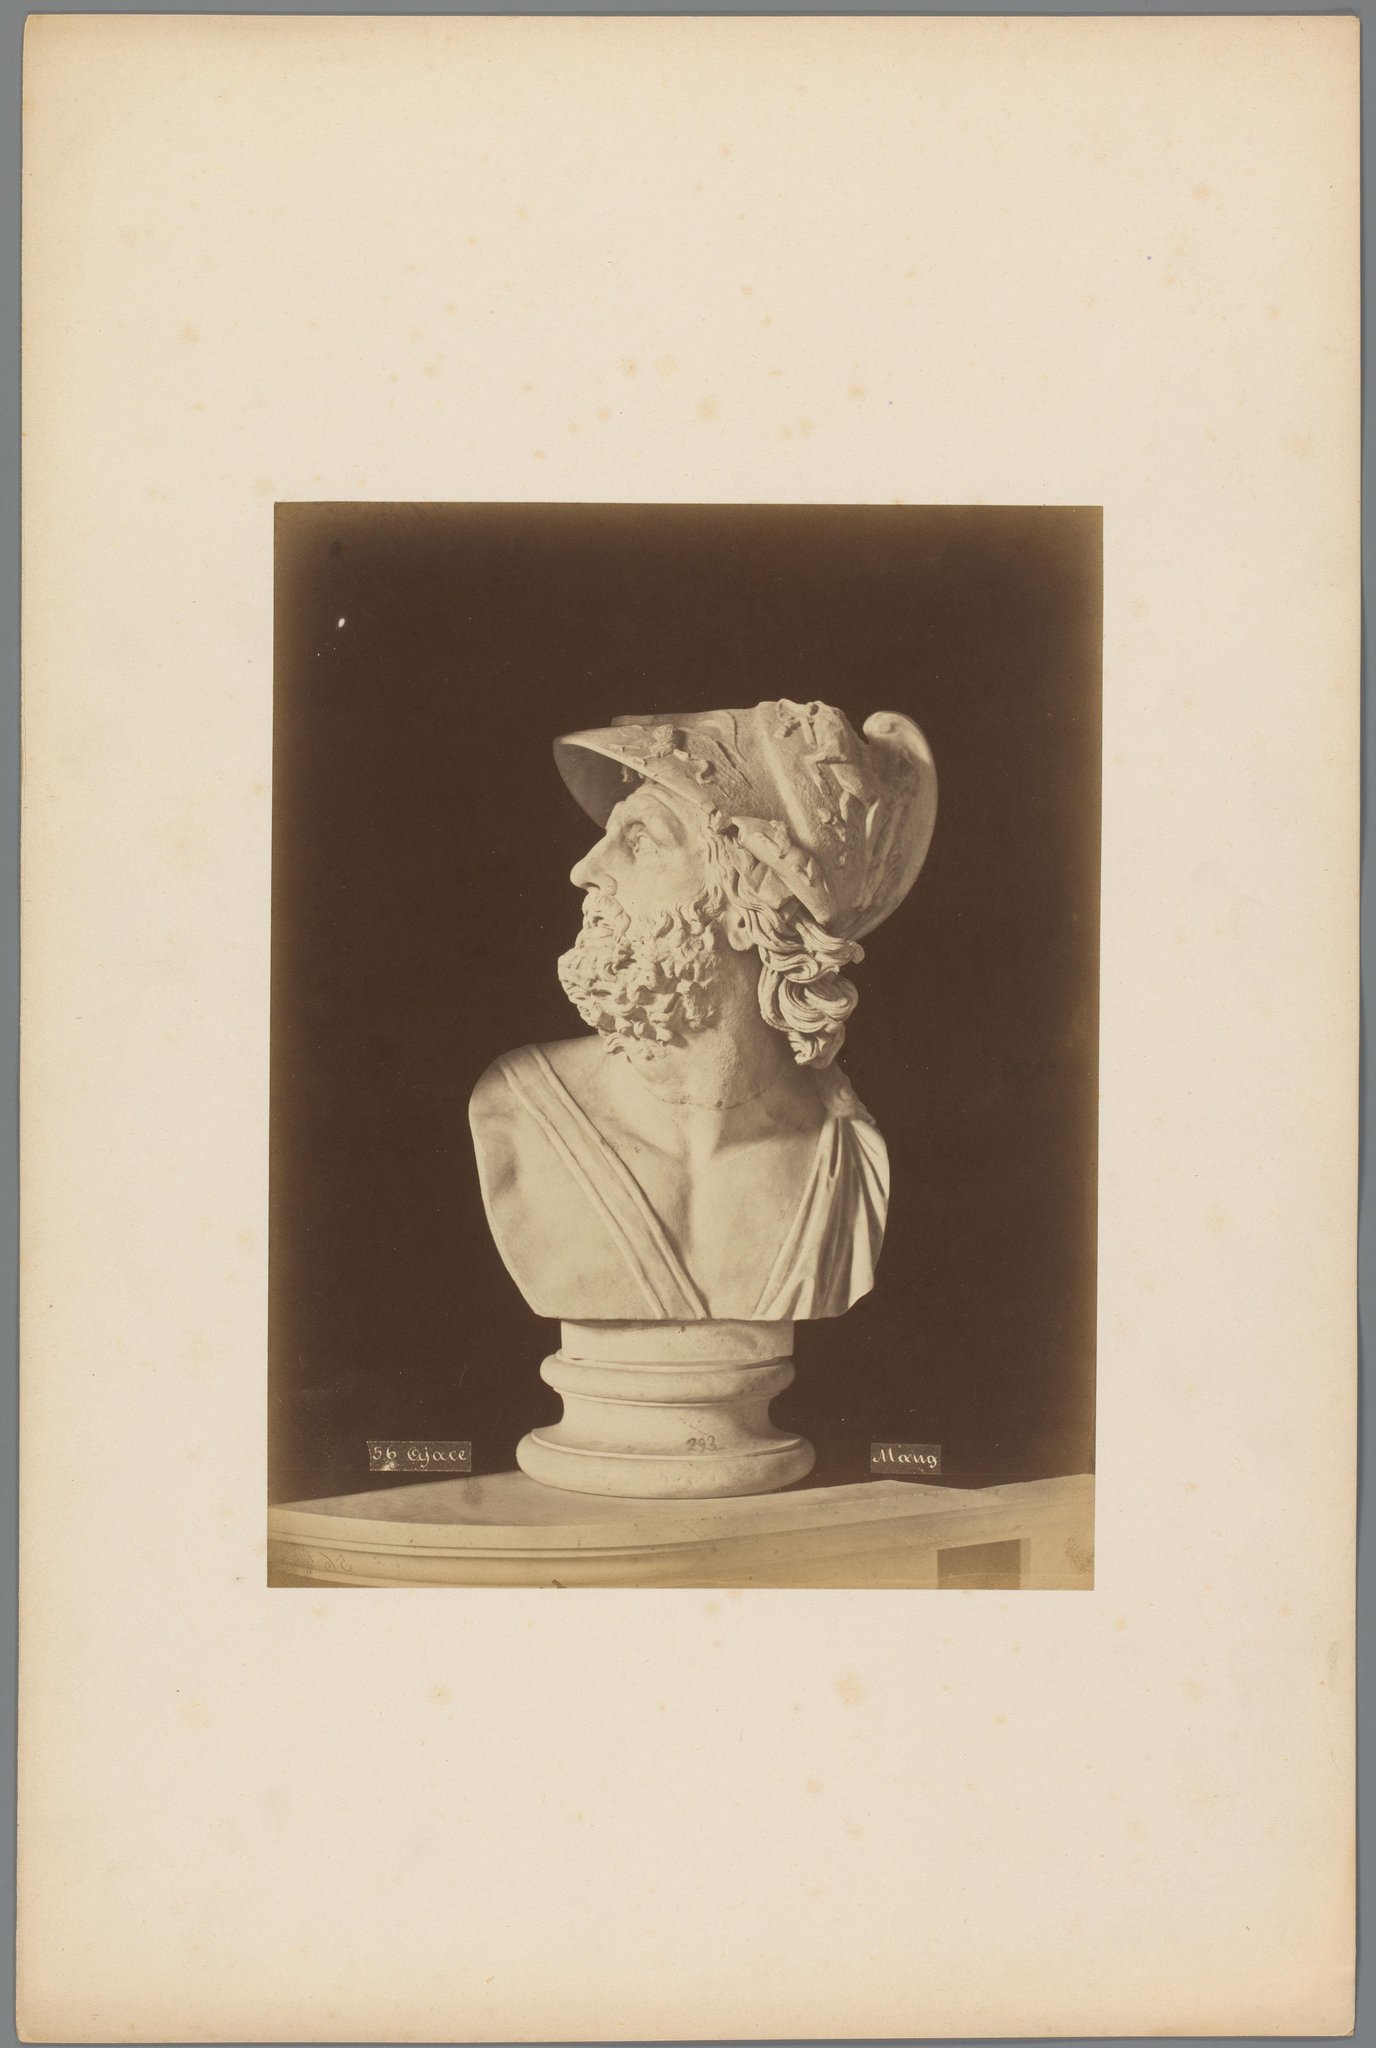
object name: photograph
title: Buste van Menelaus in de Vaticaanse Musea te Vaticaanstad, Italië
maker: michèle mang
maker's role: fotograaf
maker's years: 1840-1909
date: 1863-1887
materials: cardboard, paper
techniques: albumen print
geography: vatican city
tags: chest, bust, 95a(menelaus), sculpture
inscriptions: number: ‘56’